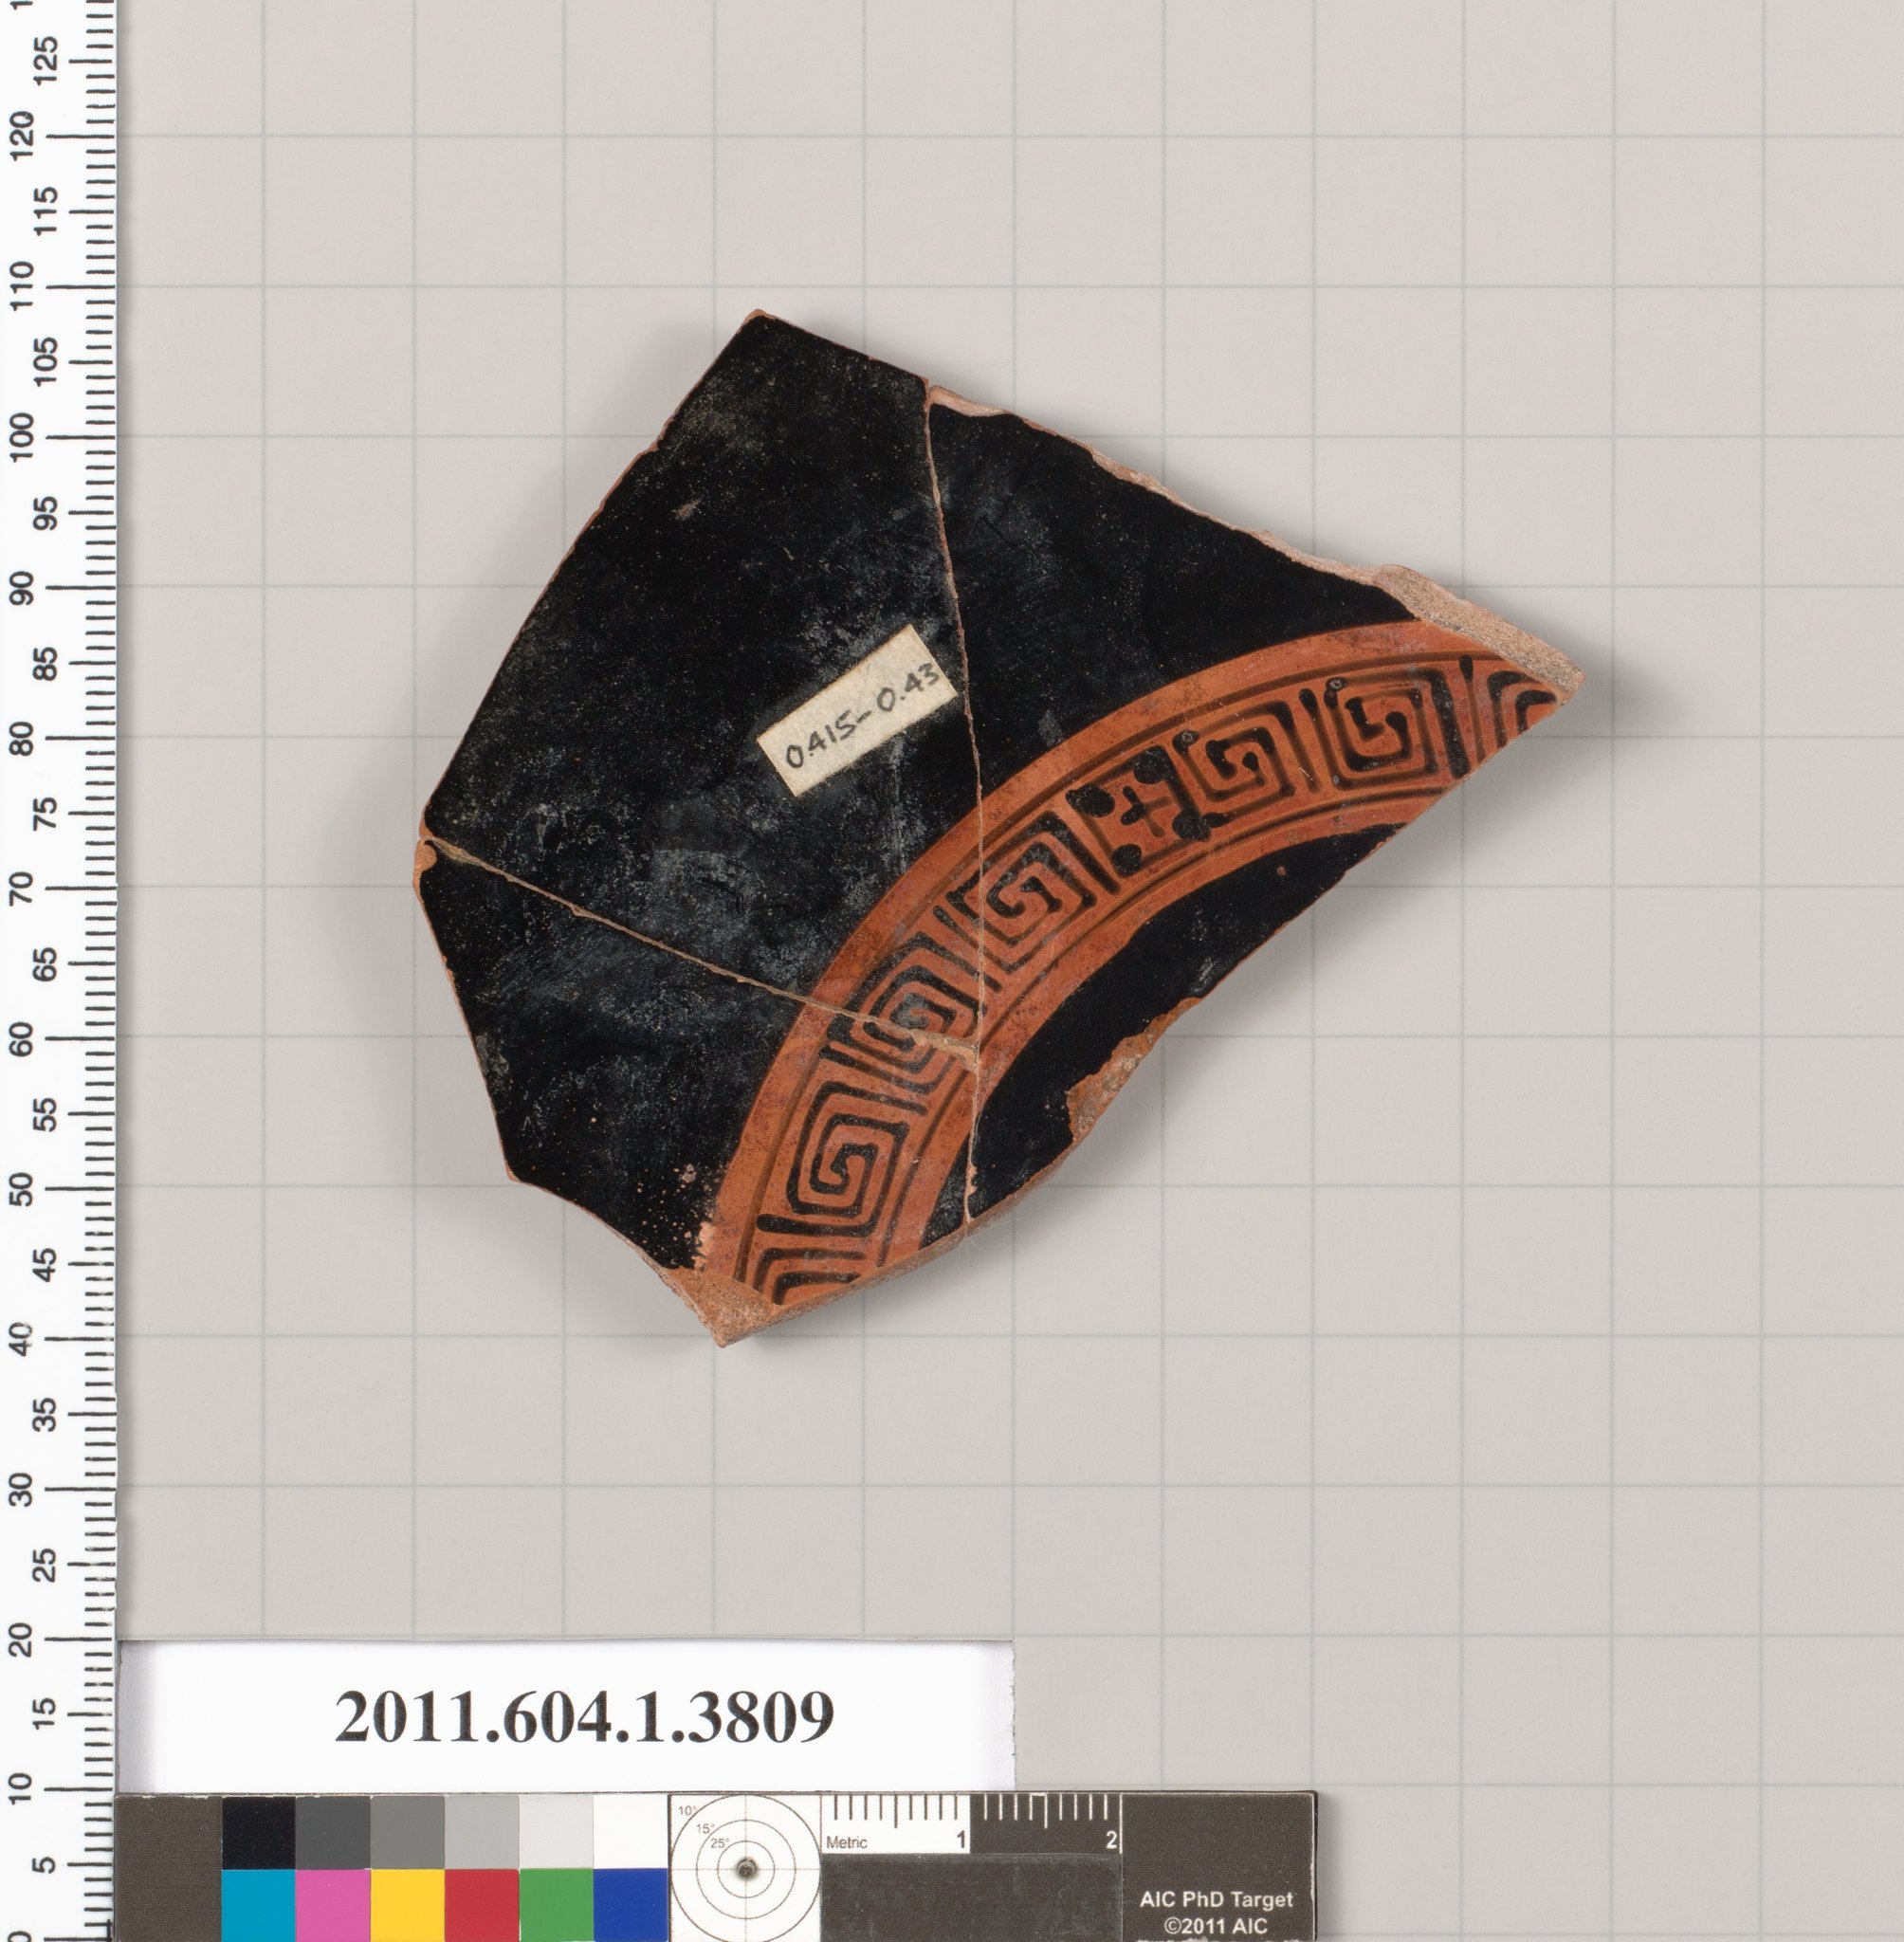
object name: kylix fragment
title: Terracotta fragment of a kylix (drinking cup)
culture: greek, attic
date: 475-451 BCE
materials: terracotta